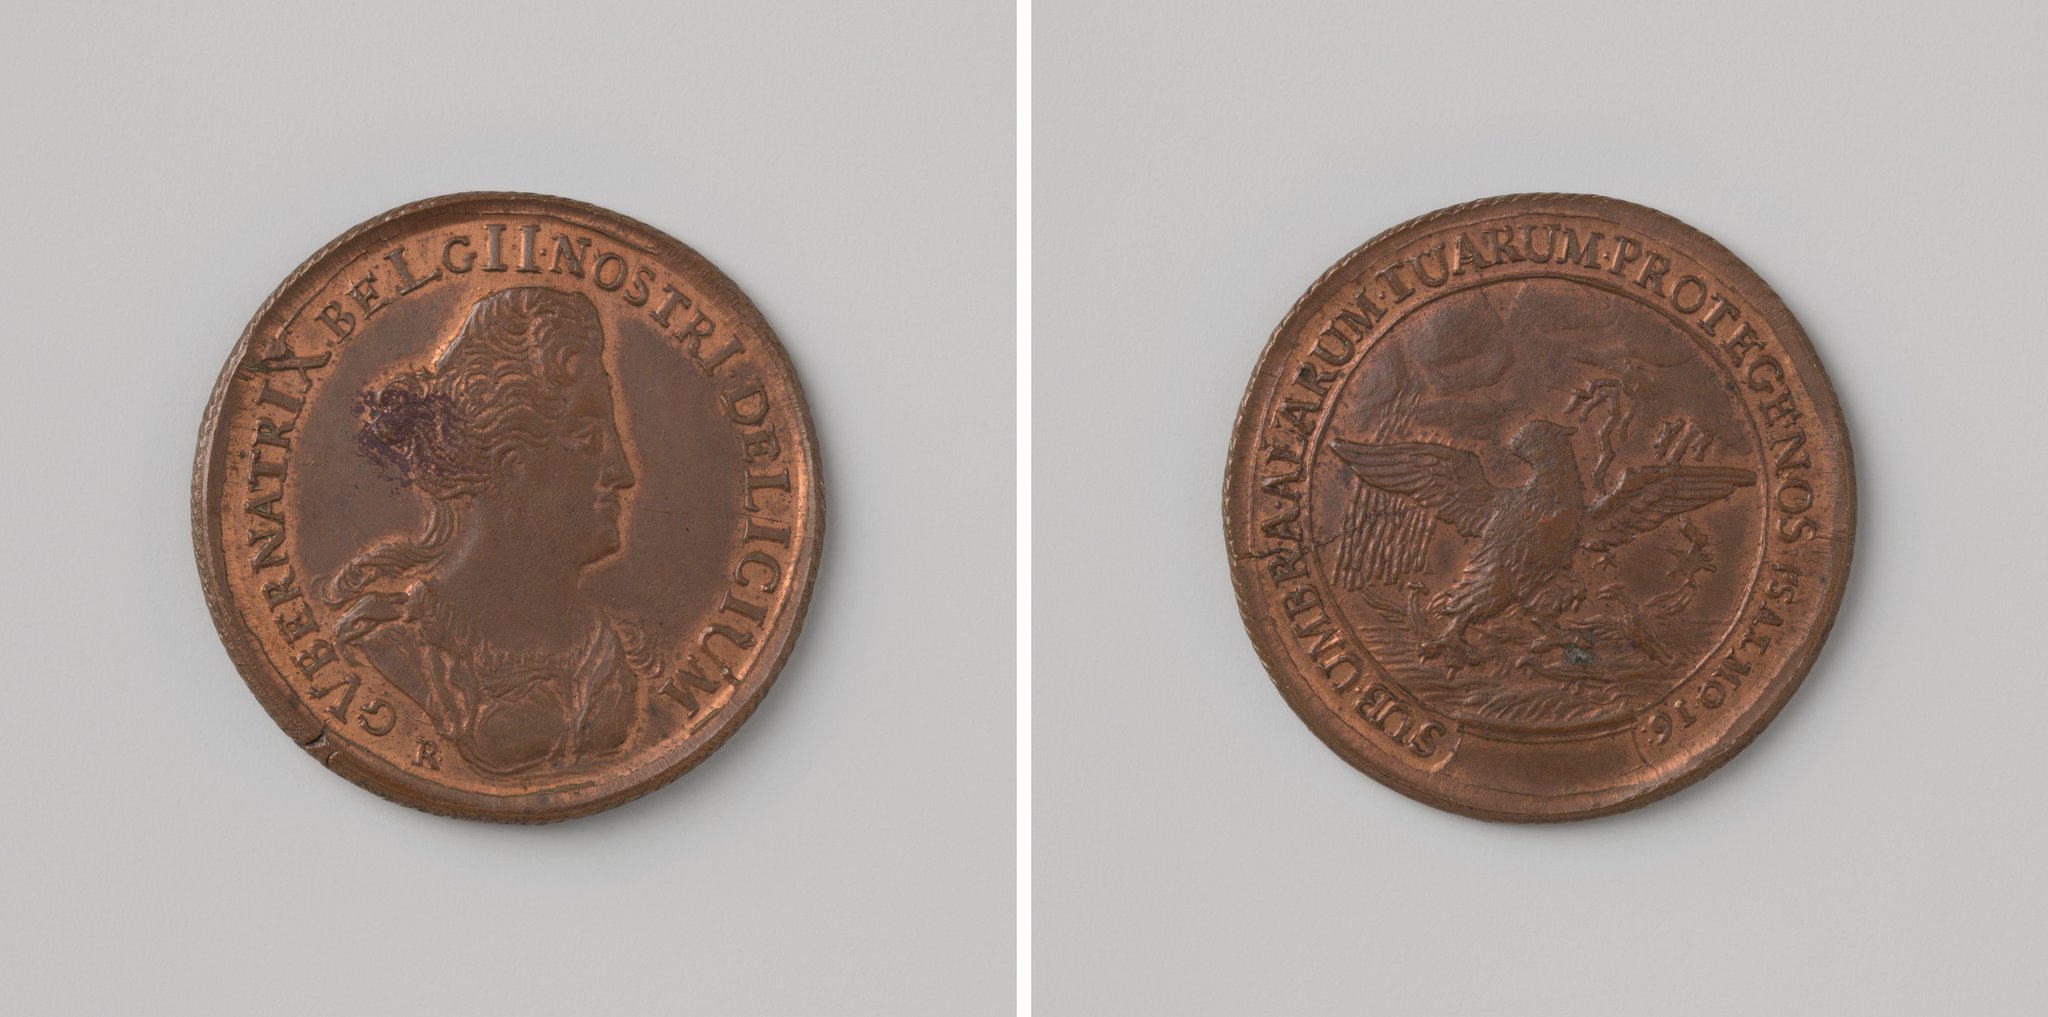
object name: new year medal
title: Maria Elisabeth van Oostenrijk, ingehuldigd als landvoogdes der zuidelijke Nederlanden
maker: philippe roëttiers (iii)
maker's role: medailleur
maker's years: 1686-1873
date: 1726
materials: bronze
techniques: striking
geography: brussels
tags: landvoogd, maria elisabeth (aartshertogin van oostenrijk)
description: Bronzen penning. Voorzijde: borststuk vrouw binnen omschrift. Keerzijde: arend beschermt met zijn uitgespreide vleugels zijn jongen, die angstig beschutting zoeken voor regen en bliksem binnen omschrift